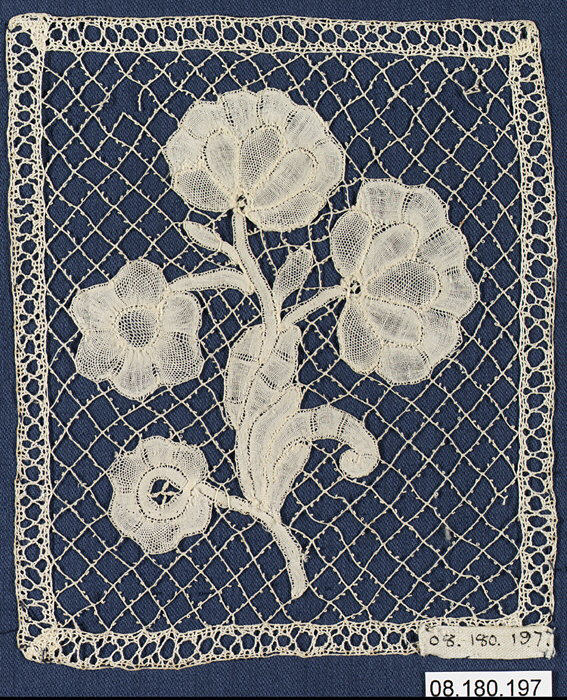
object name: square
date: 1801-1900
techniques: lace